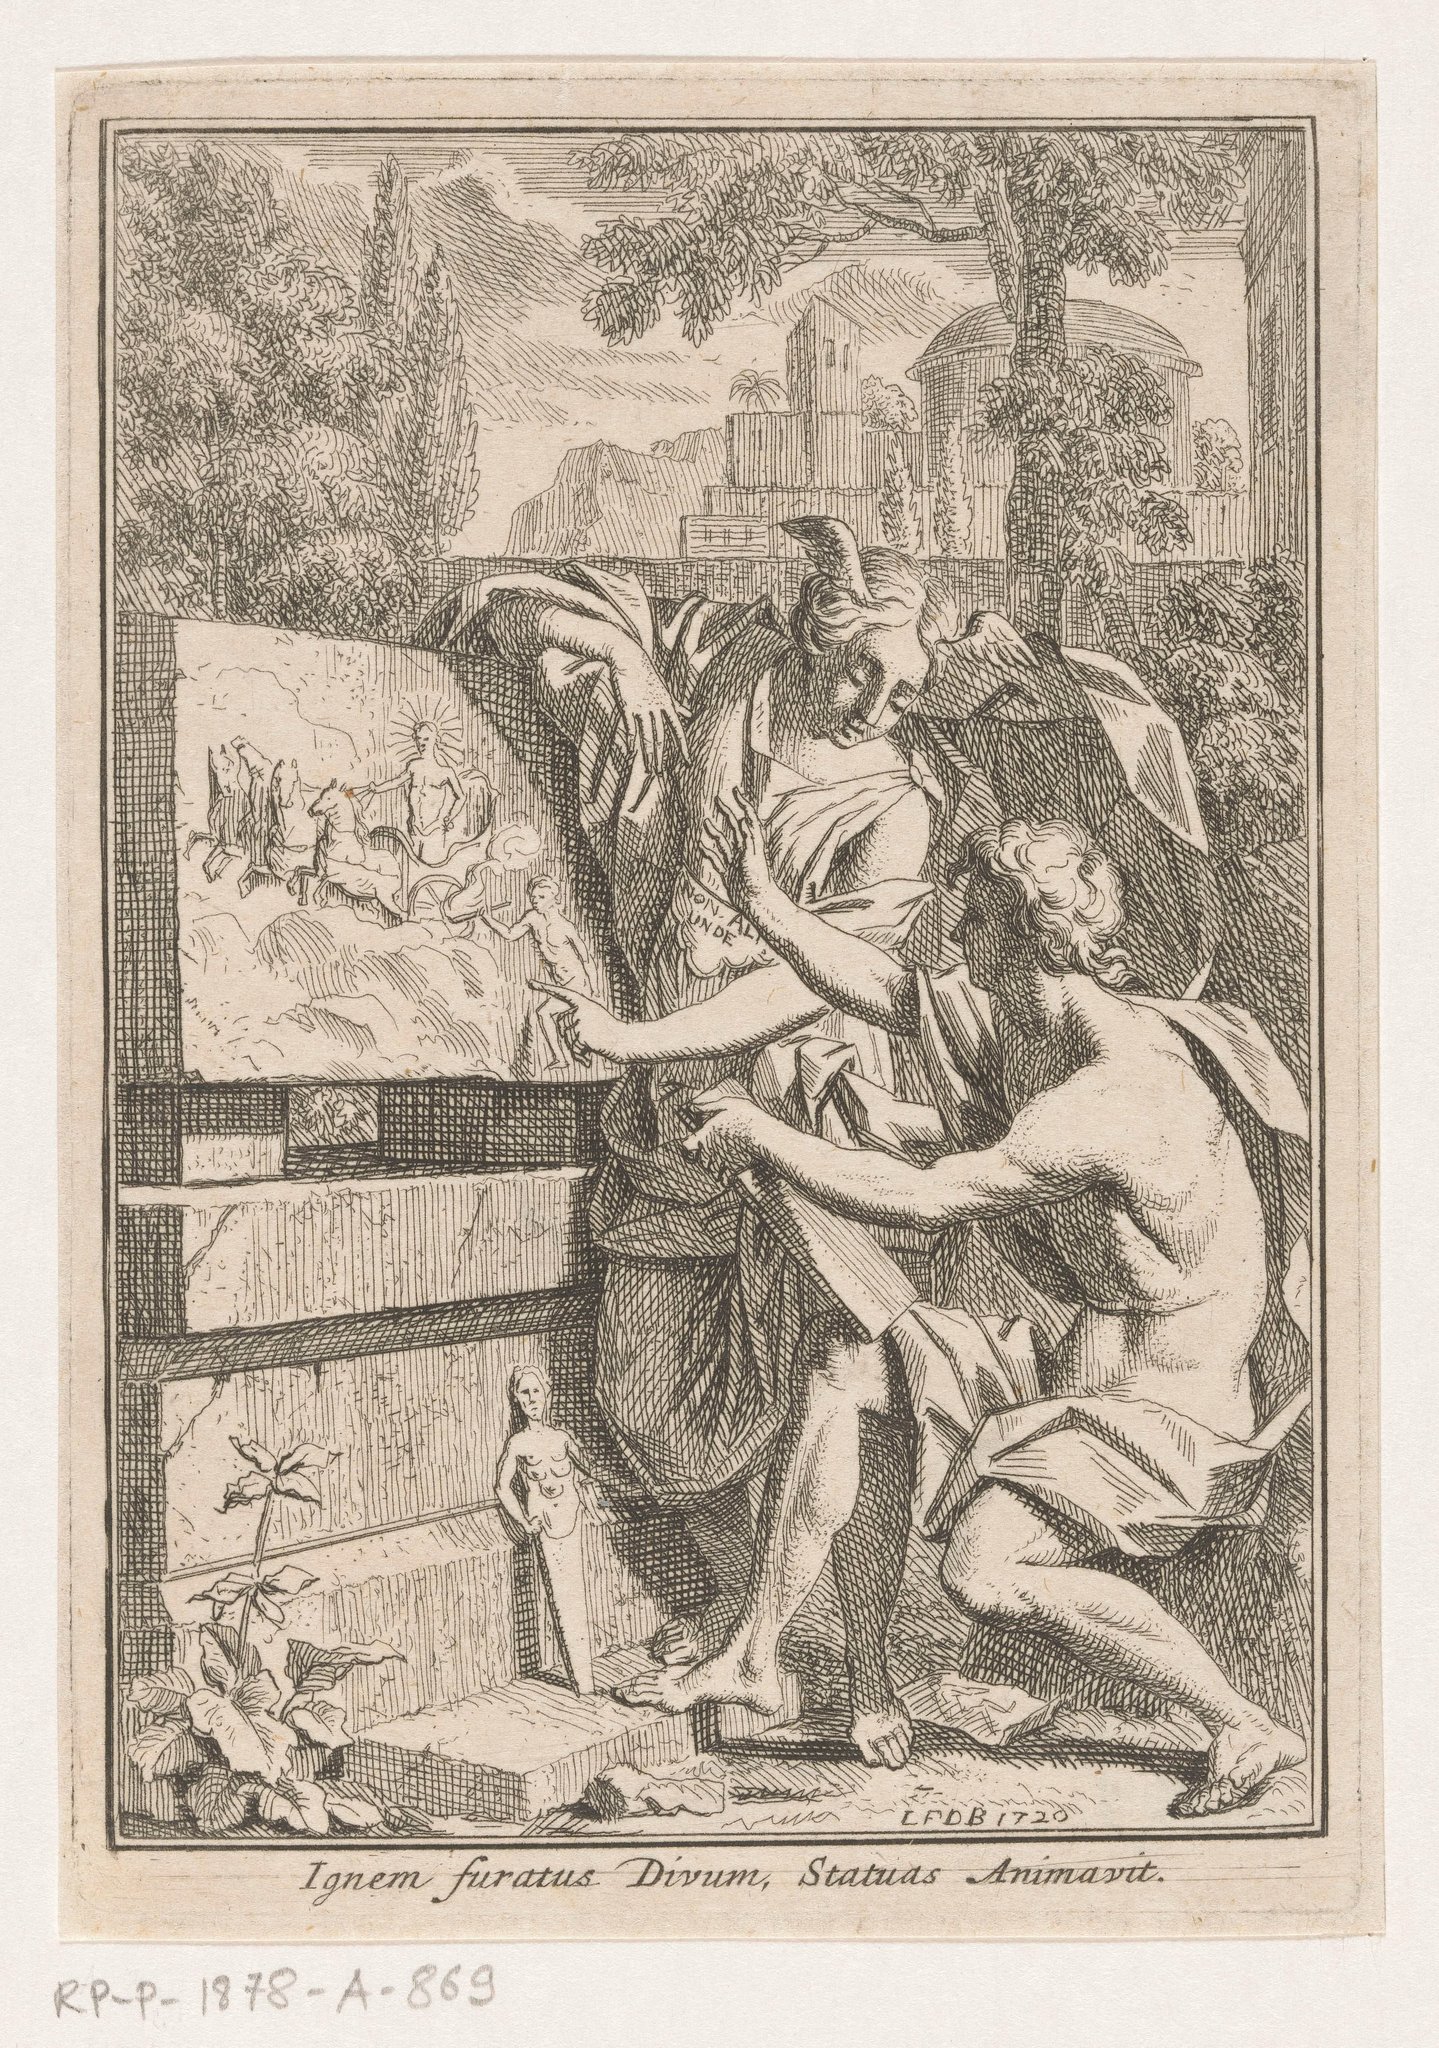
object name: print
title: Vrouw met gevleugeld hoofd toont bas-reliëf aan jonge man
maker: louis fabritius dubourg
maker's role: draughtsman, print maker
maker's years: 1693-1775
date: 1720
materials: paper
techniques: etching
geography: amsterdam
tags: piece of sculpture, reproduction of a piece of sculpture, attributes of apollo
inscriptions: collector's mark: Lugt 2228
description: Een vrouw met vleugels aan haar hoofd toont een enthousiaste jonge man een bas-reliëf met een afbeelding van Apollo in zijn zonnewagen.